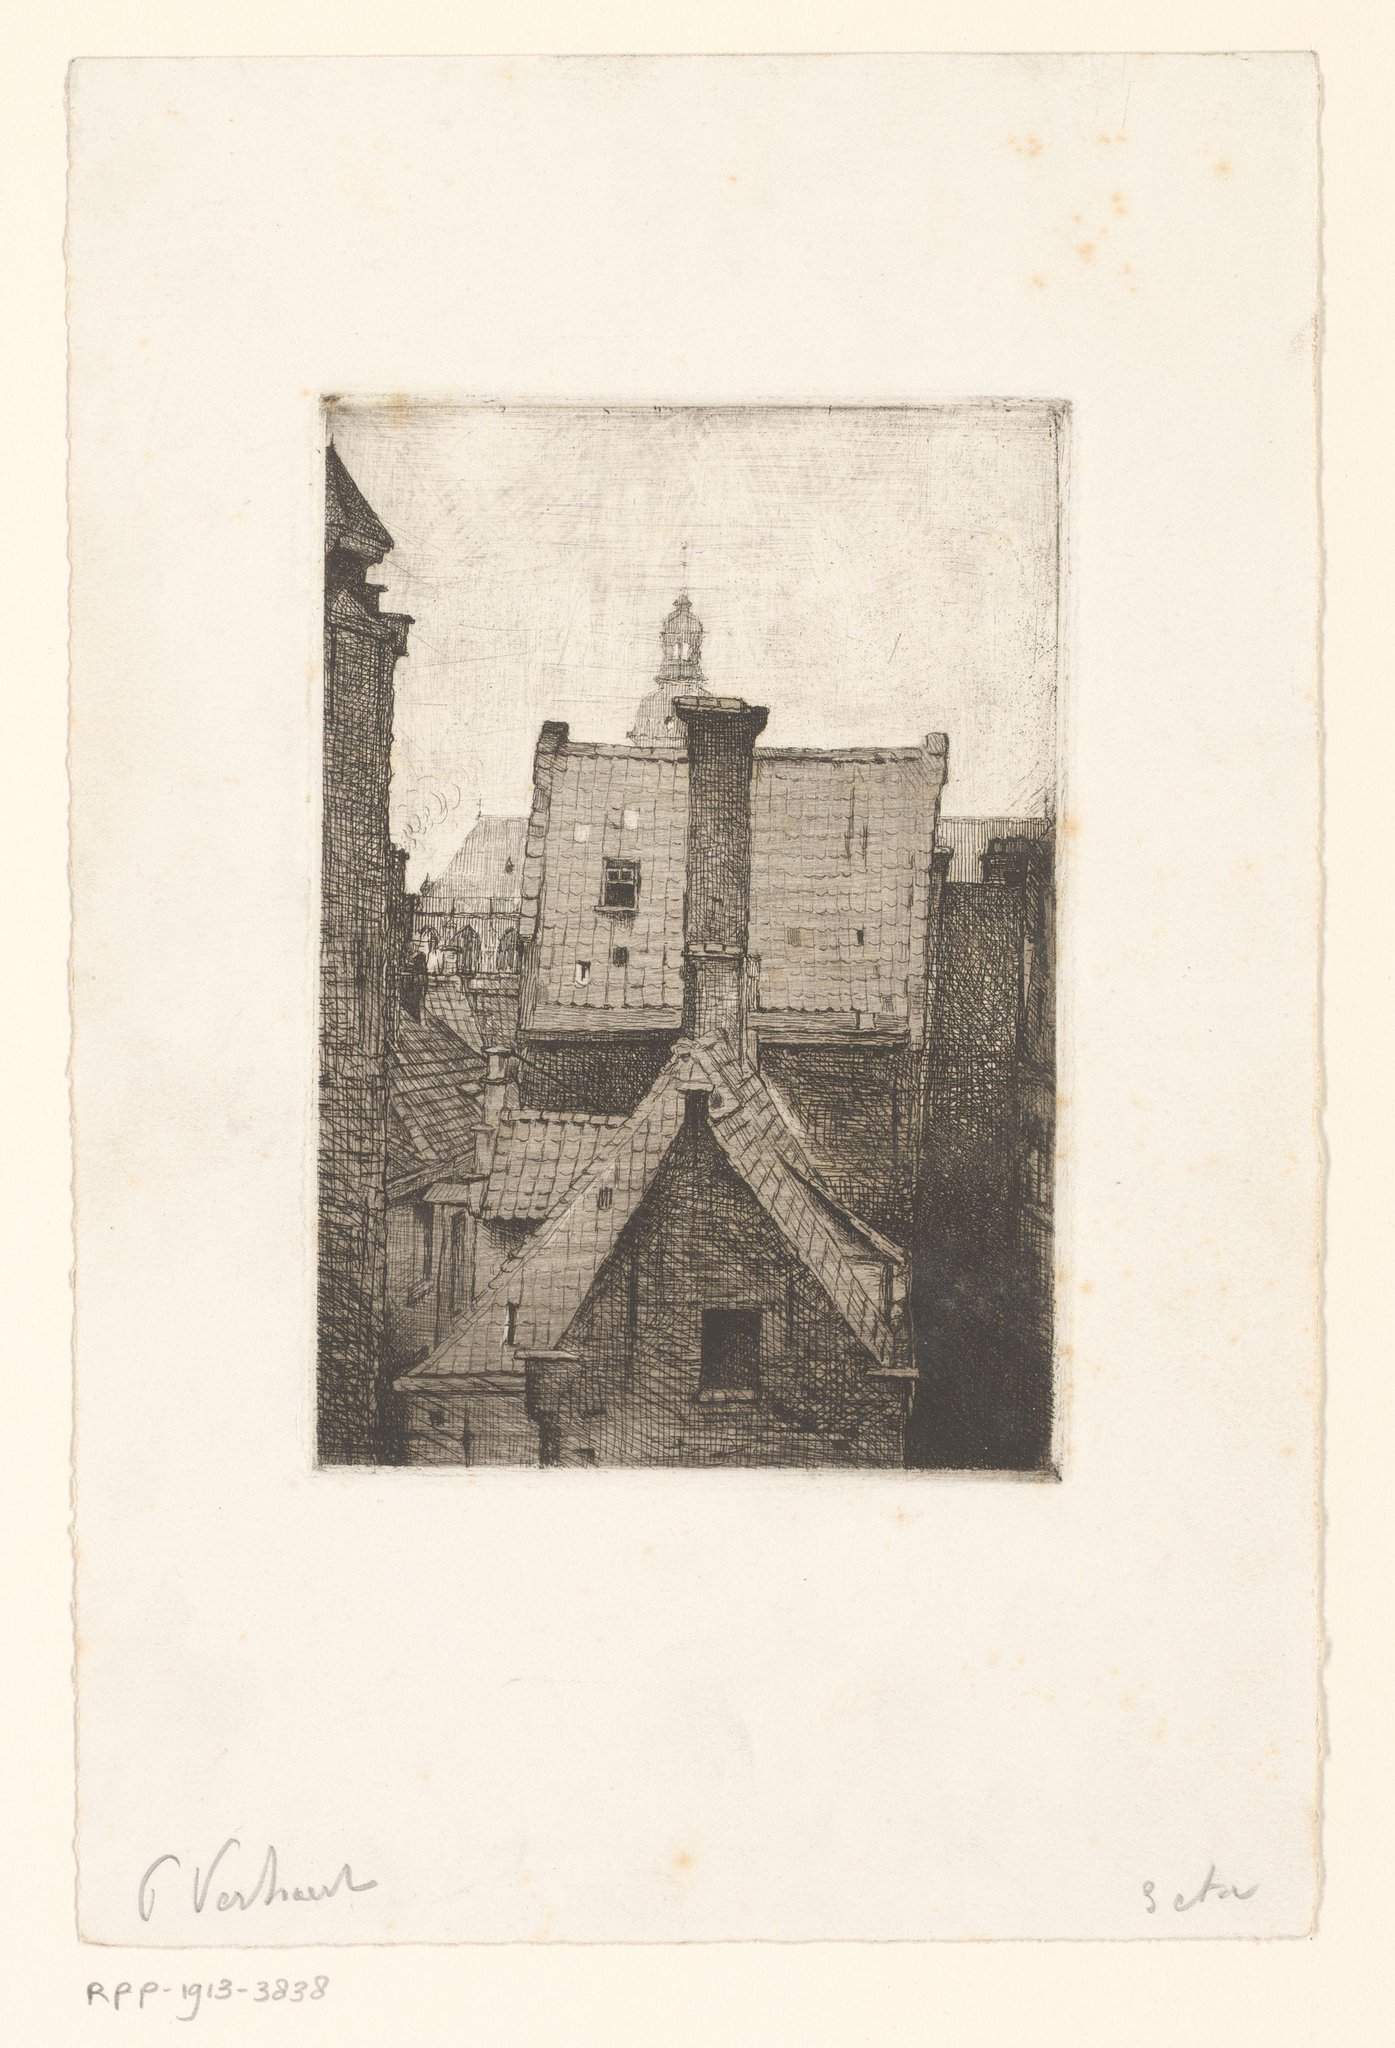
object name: print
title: Gezicht op daken met een schoorsteen, op de achtergrond een kerk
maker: piet verhaert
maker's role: print maker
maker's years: 1852-1908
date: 1862-1908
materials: paper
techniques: etching, intaglio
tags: roof (of house or building), housing, church (exterior)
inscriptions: collector's mark: Lugt 2228, inscription: ‘3 eta’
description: Mogelijk gaat het om de Sint-Pauluskerk te Antwerpen.